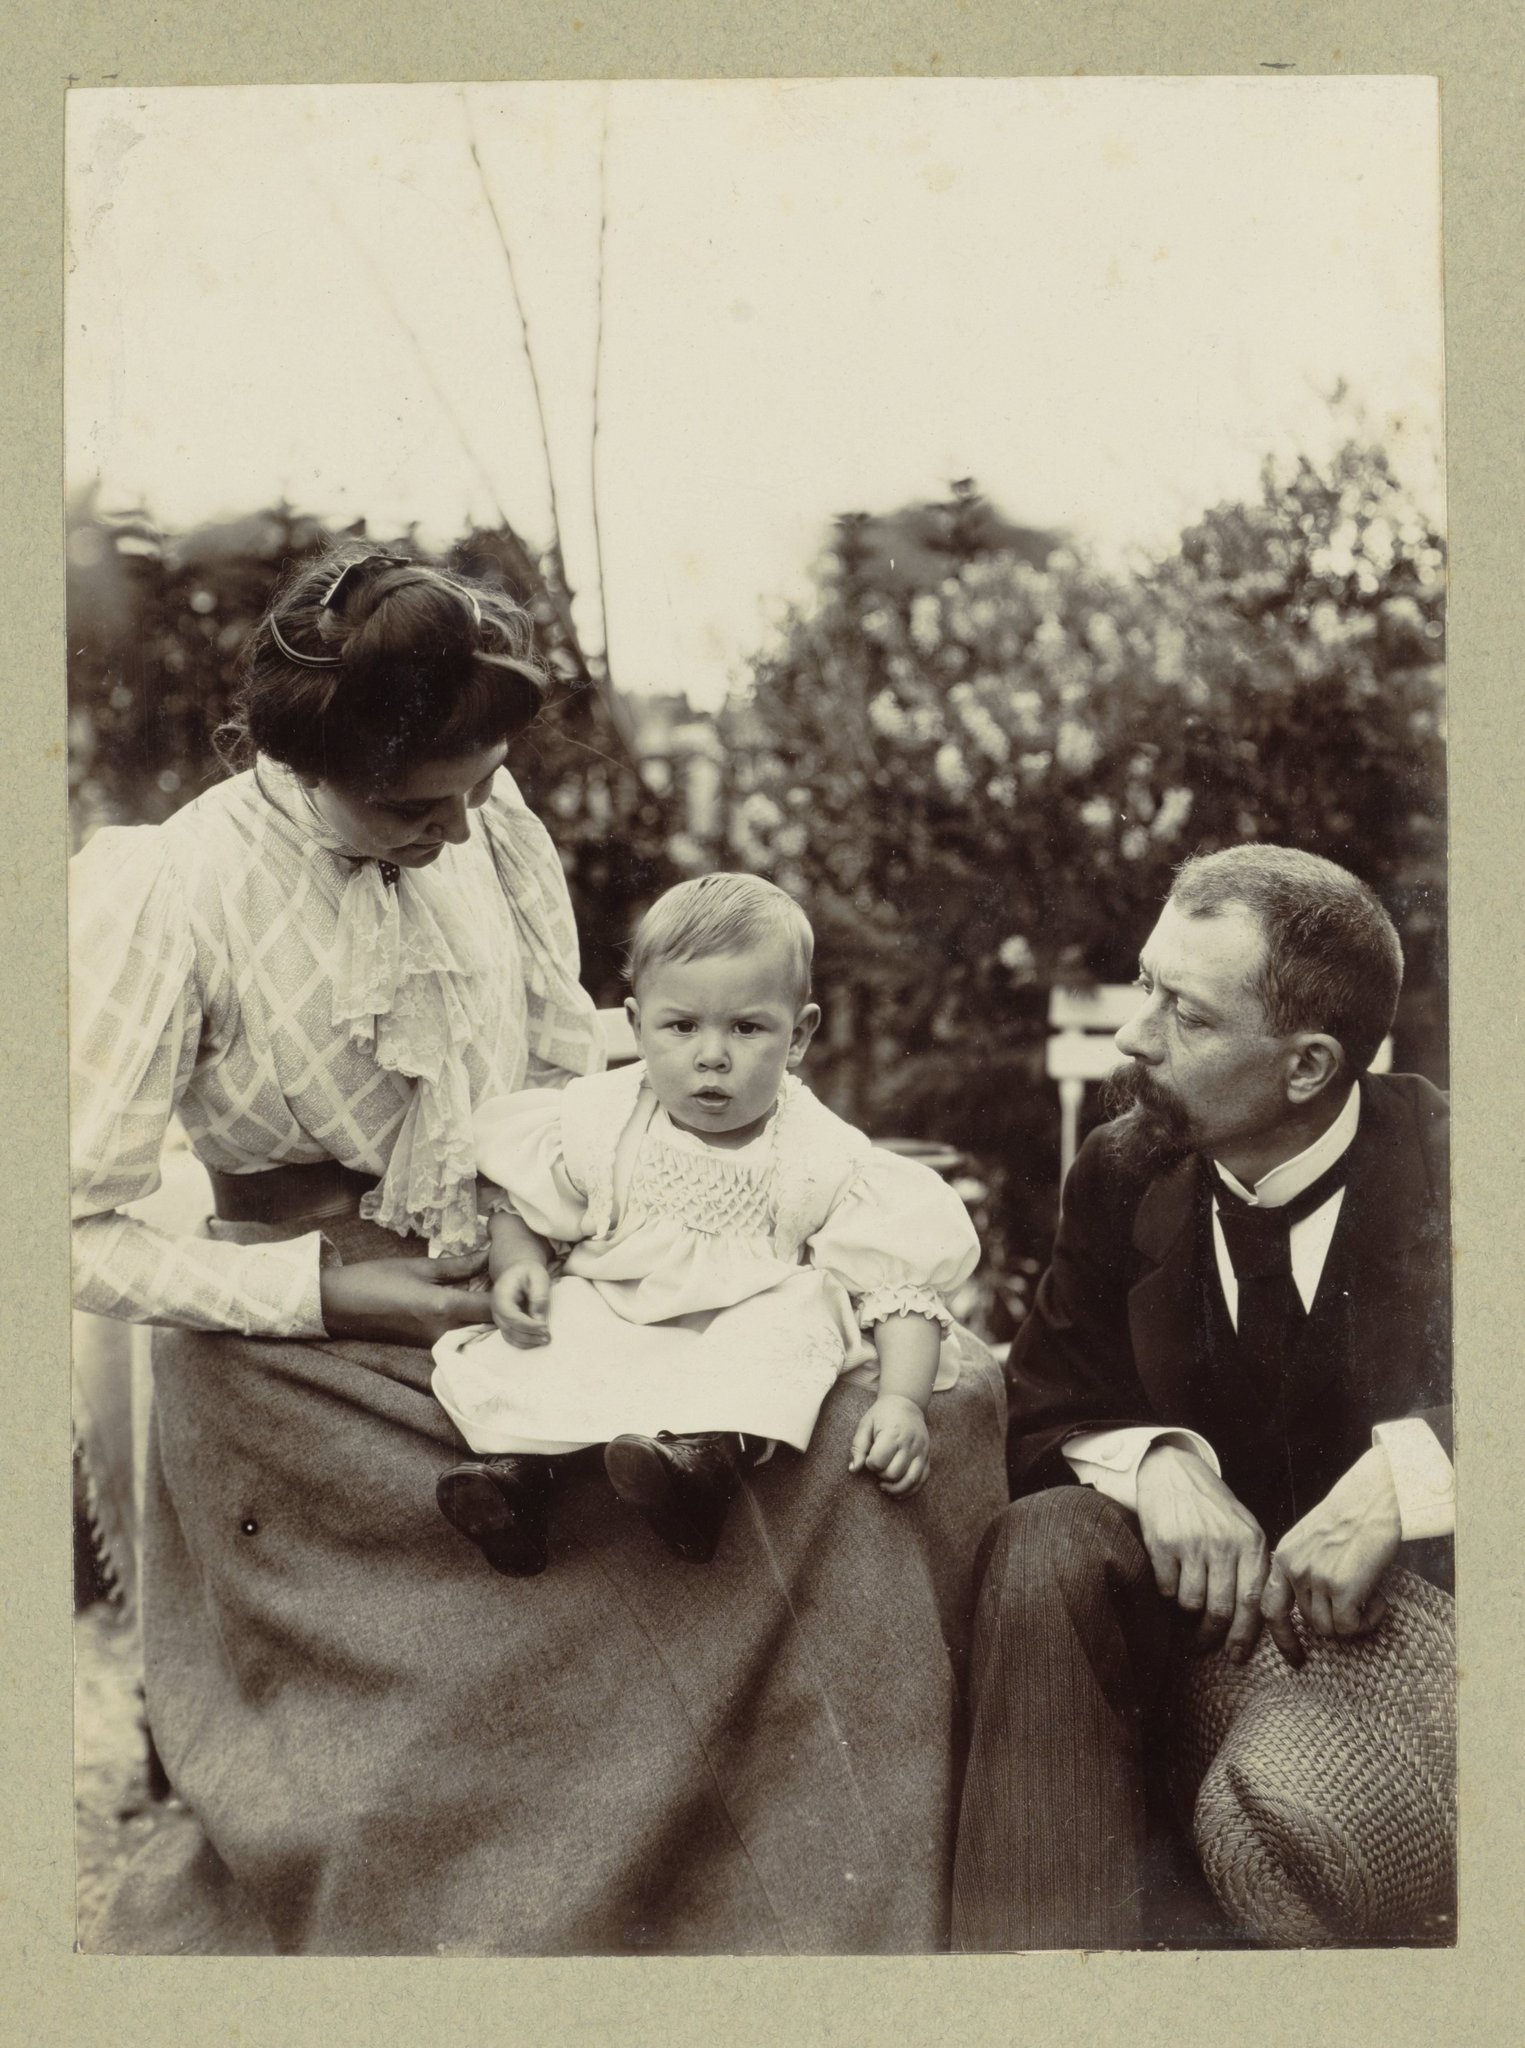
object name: photograph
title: Man en een vrouw met een baby op schoot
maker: Anonymous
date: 1885-1914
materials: photographic support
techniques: gelatin silver print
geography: france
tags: family group, especially parents with their child(ren), france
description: Onderdeel van Fotoalbum met familiefoto's.